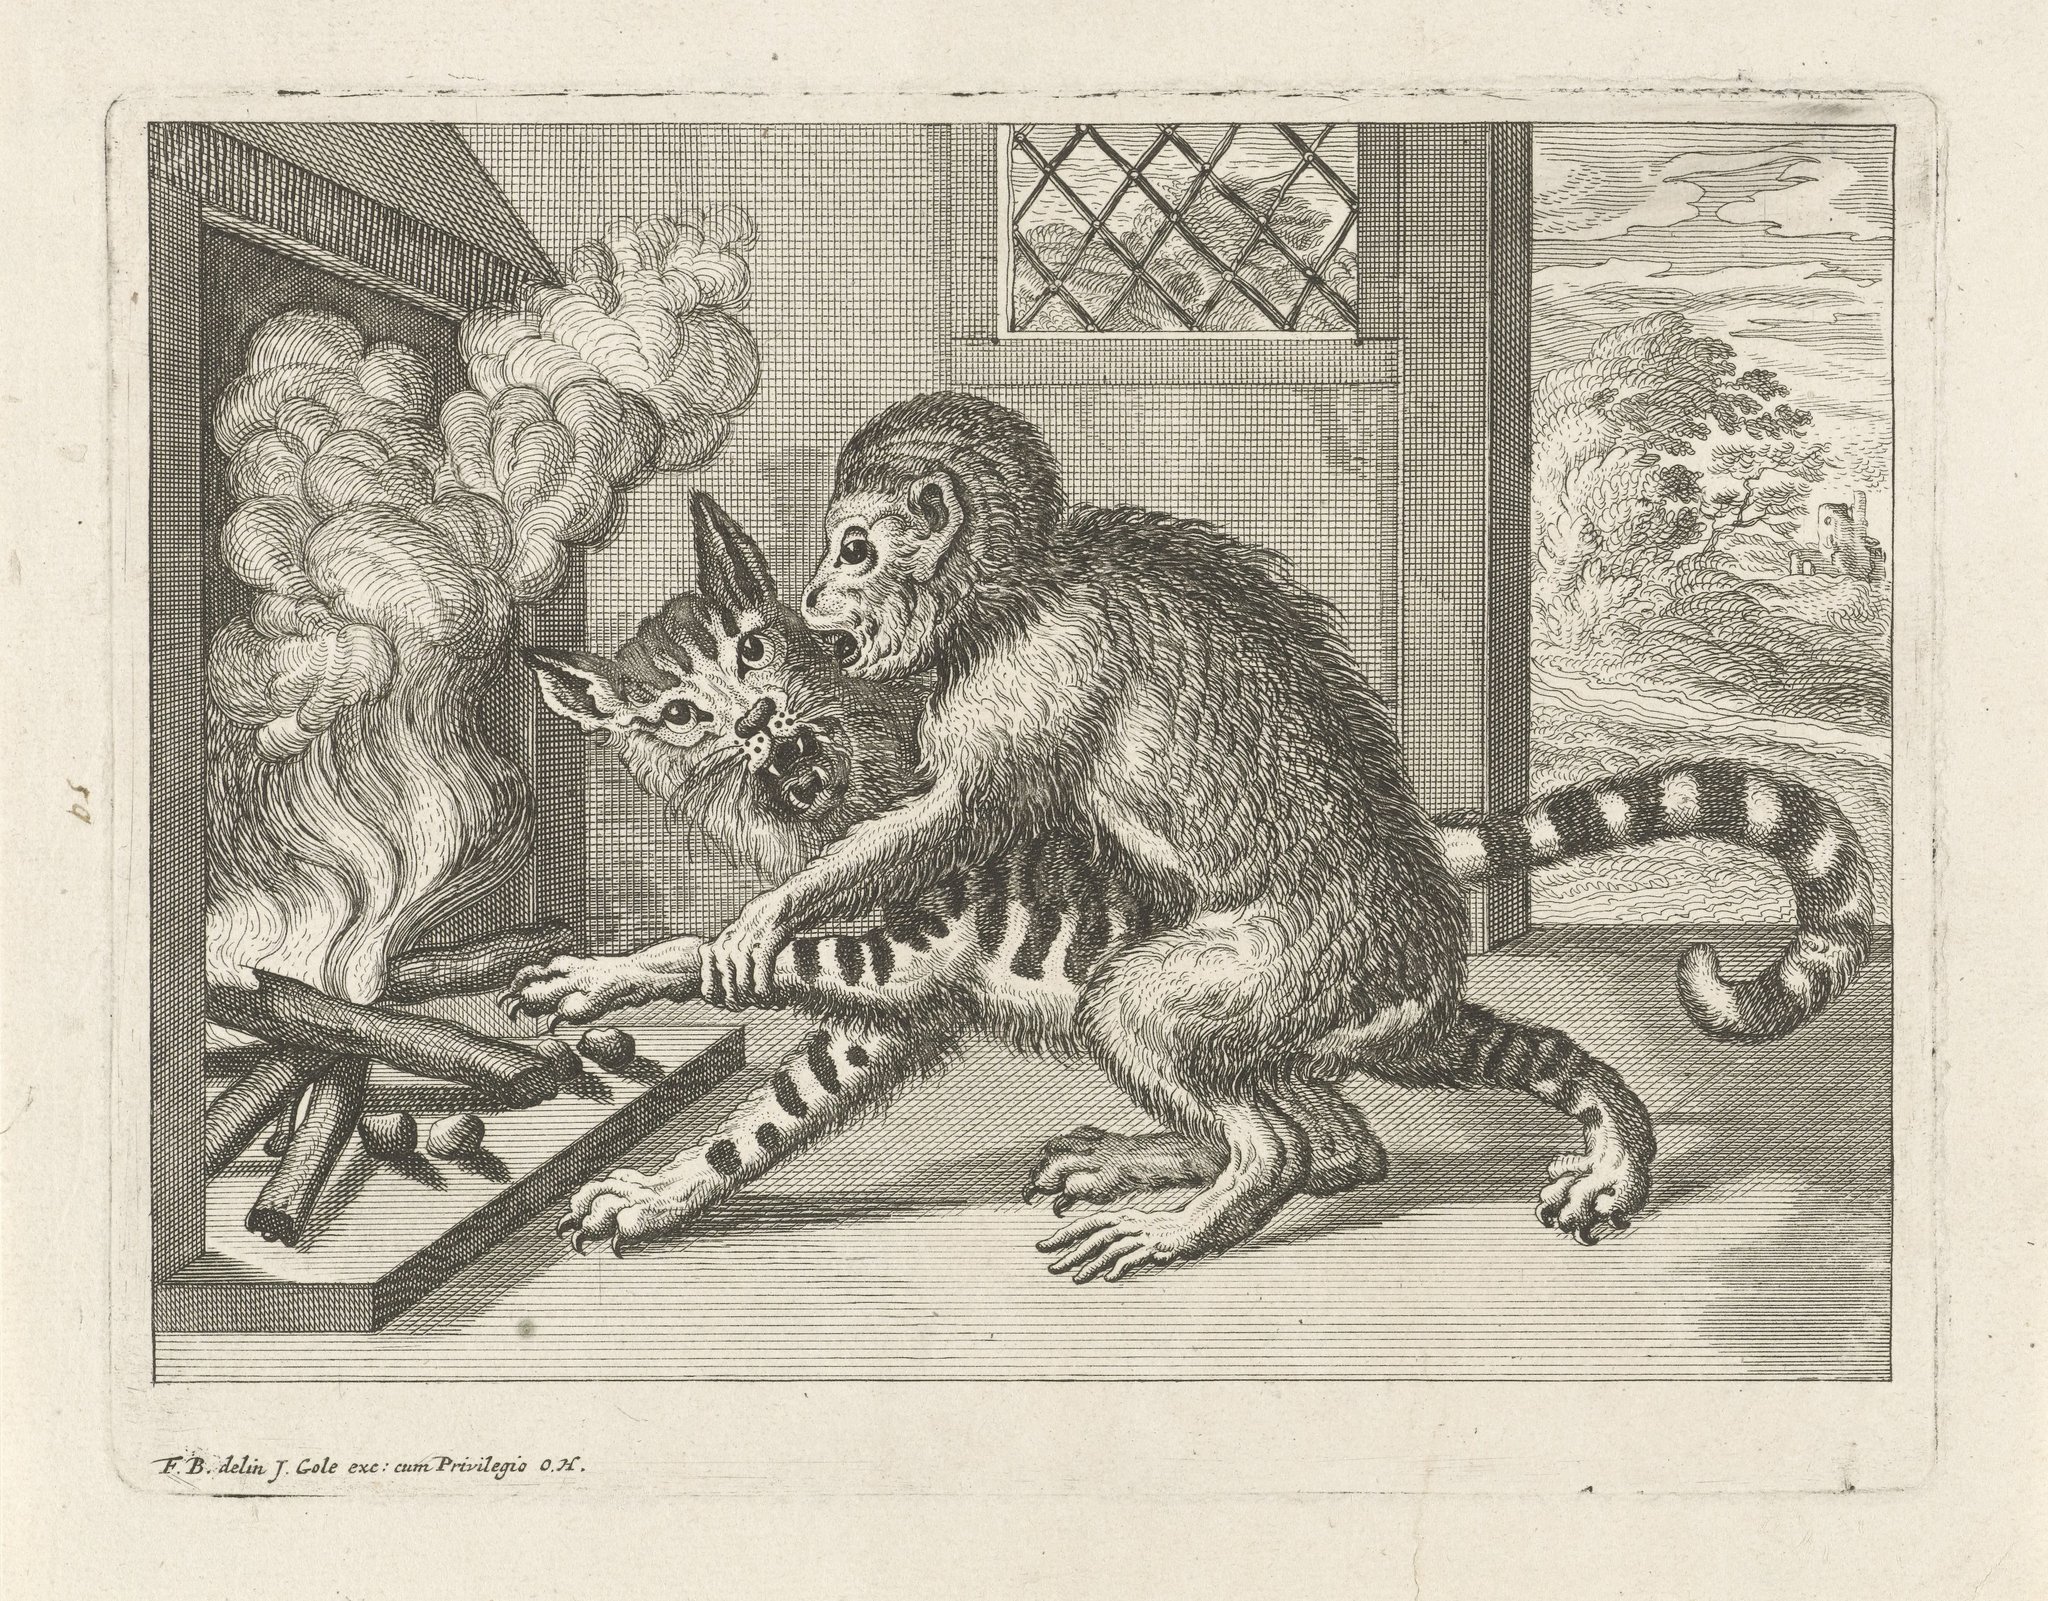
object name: print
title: Aap dwingt een kat de kastanjes uit het vuur te halen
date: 1680-1723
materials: paper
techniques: engraving, etching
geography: amsterdam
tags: cat, monkeys, apes, open hearth, fire-place, fruits: chestnut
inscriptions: collector's mark: Lugt 2228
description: In een vertrek houdt een aap de poot van een kat bij het vuur van de haard. In het haardvuur liggen kastanjes. Deze prent maakt deel uit van een serie van tien prenten met verschillende dieren.